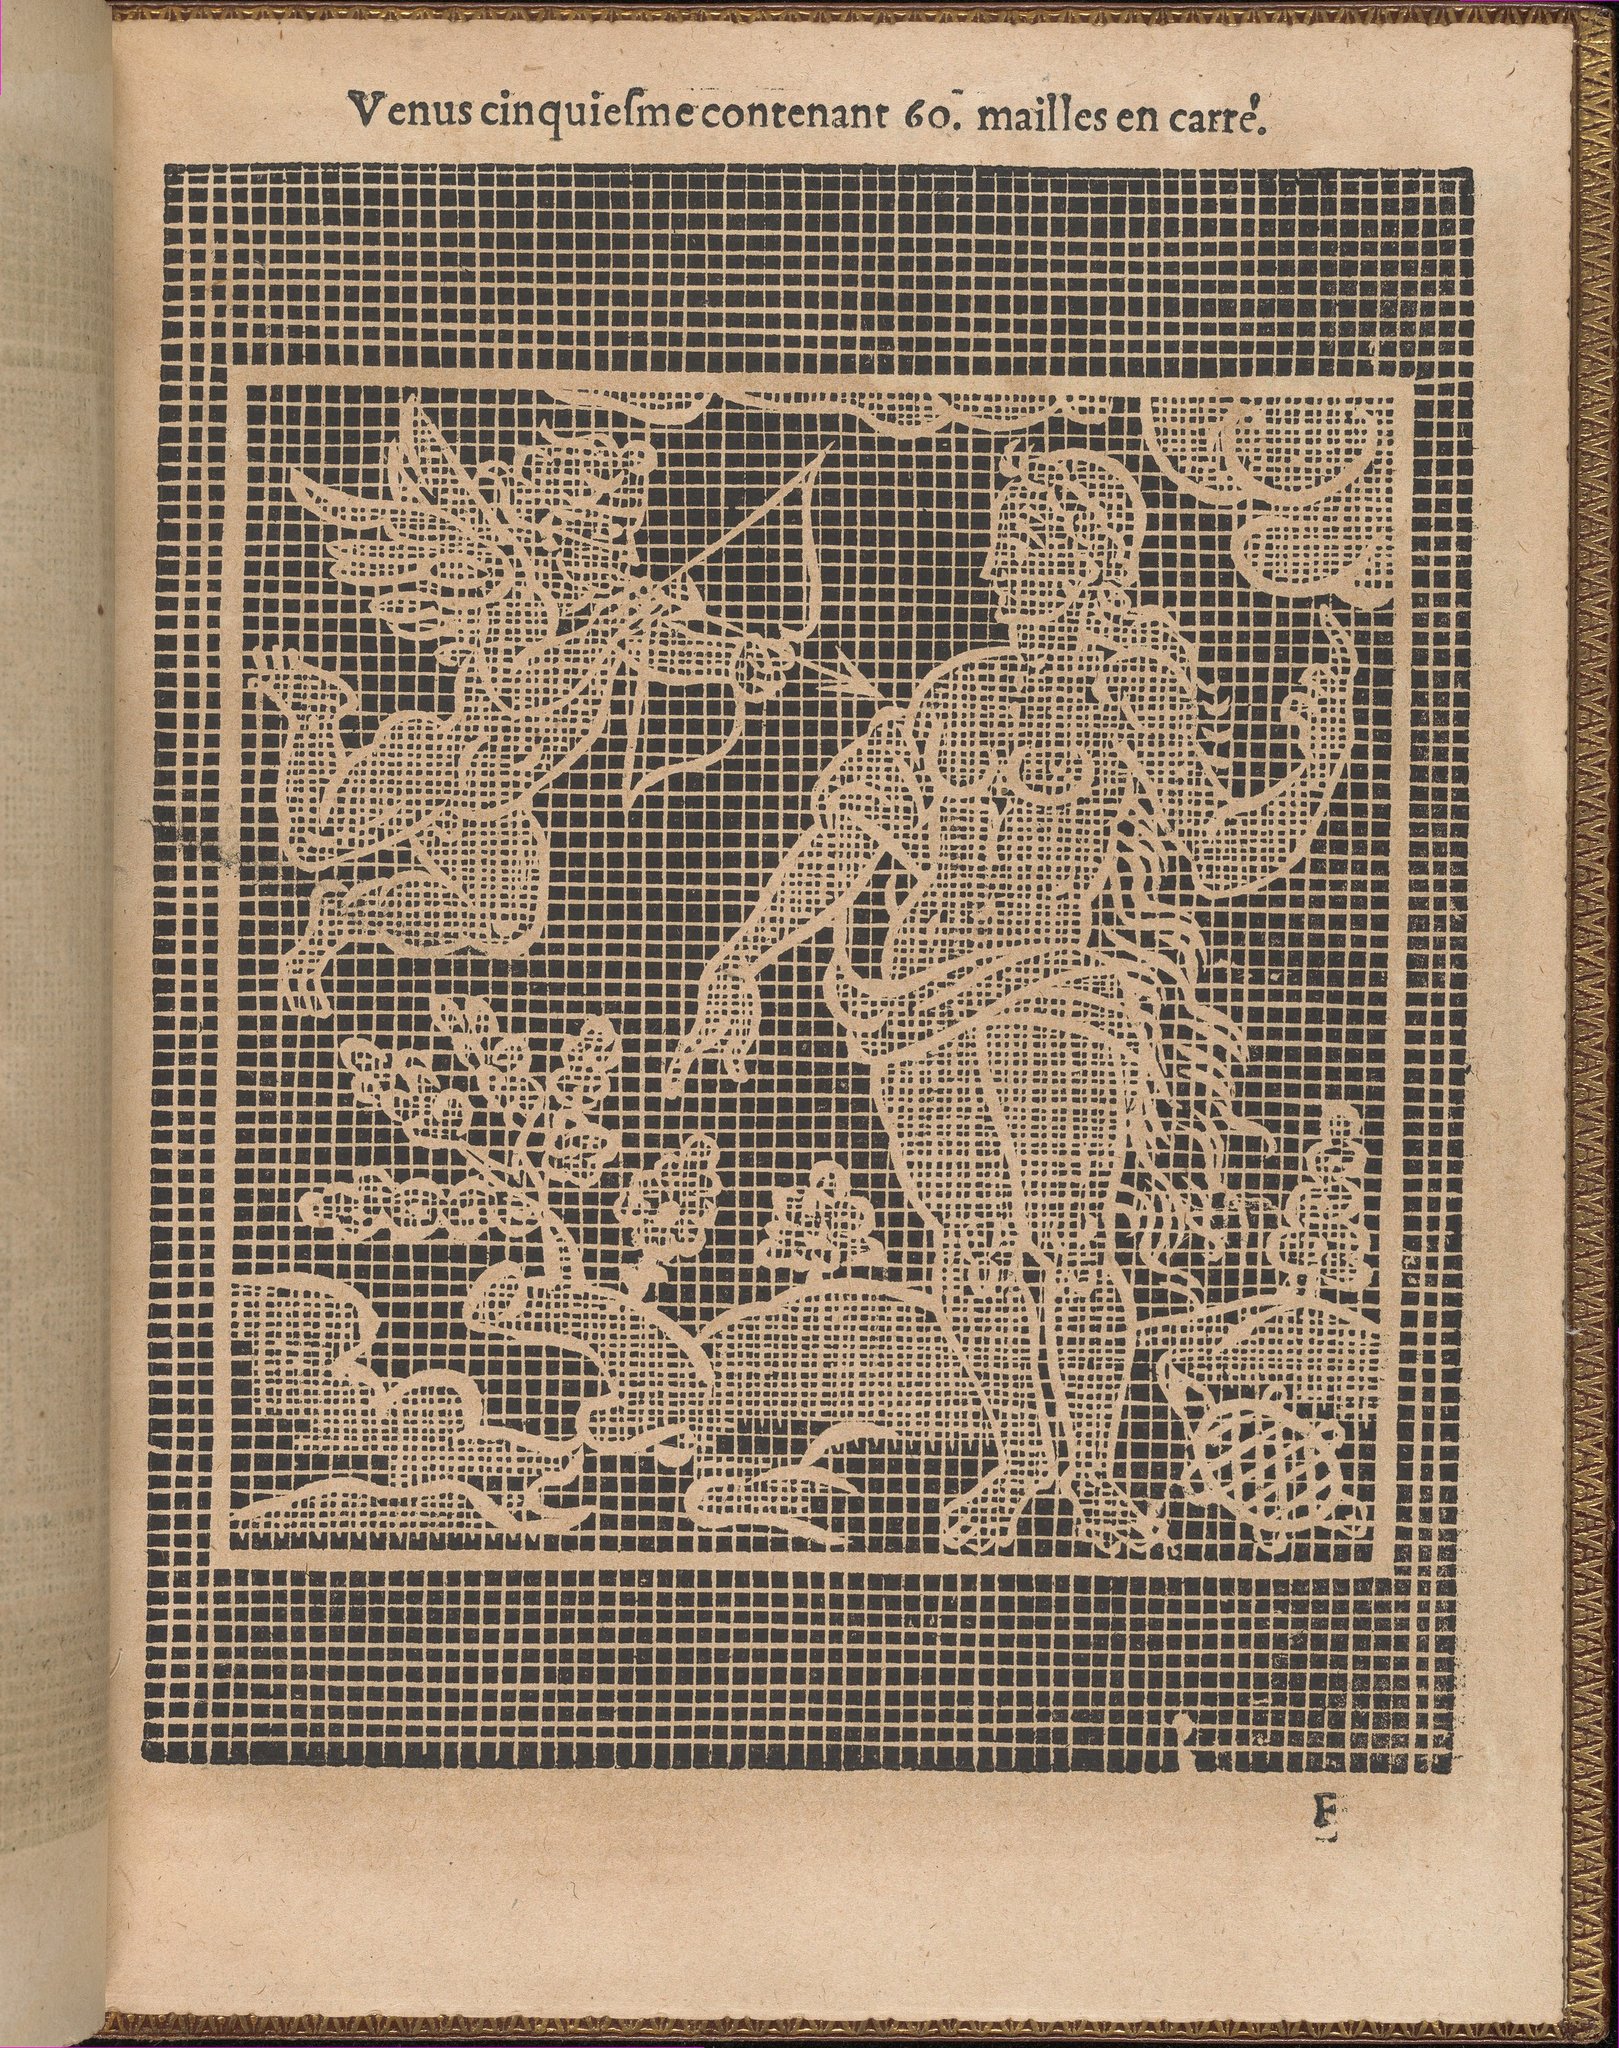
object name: book print ornament architecture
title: La Pratique de l'Aiguille, page 20 (recto)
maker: matthias mignerak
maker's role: author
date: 1605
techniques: woodcut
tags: cupid,venus